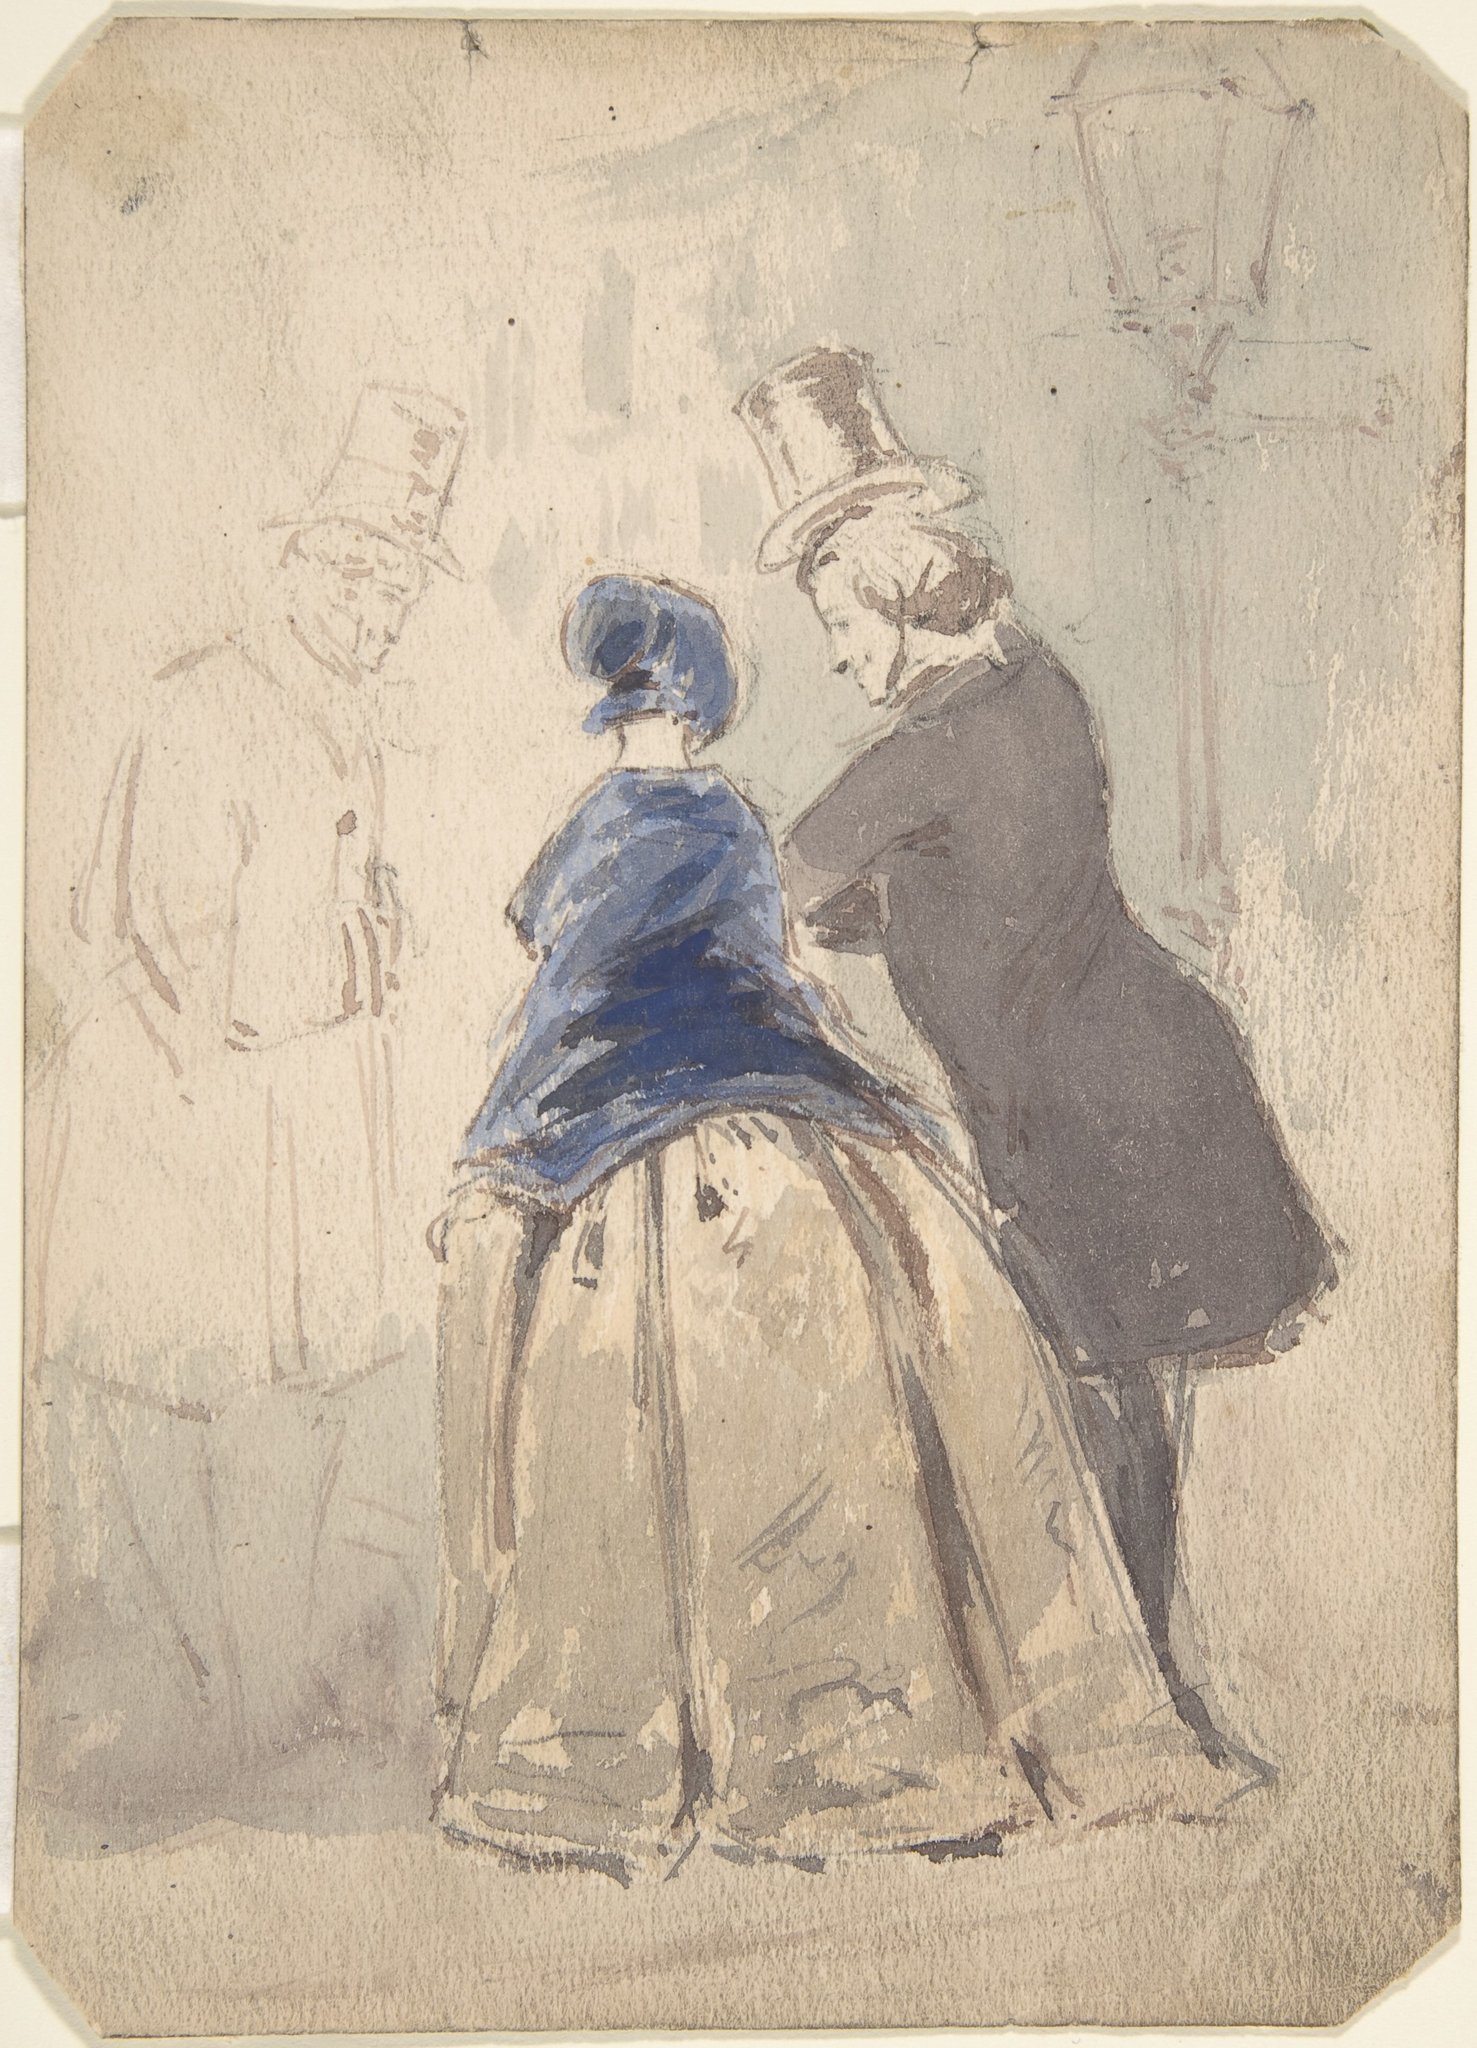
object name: drawing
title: Design for an illustration to Vanity Fair (recto); Sketch of young woman (verso)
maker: william makepeace thackeray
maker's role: artist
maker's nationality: british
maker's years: 1811-1863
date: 1847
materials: graphite, watercolor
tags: streets,hats,men,women